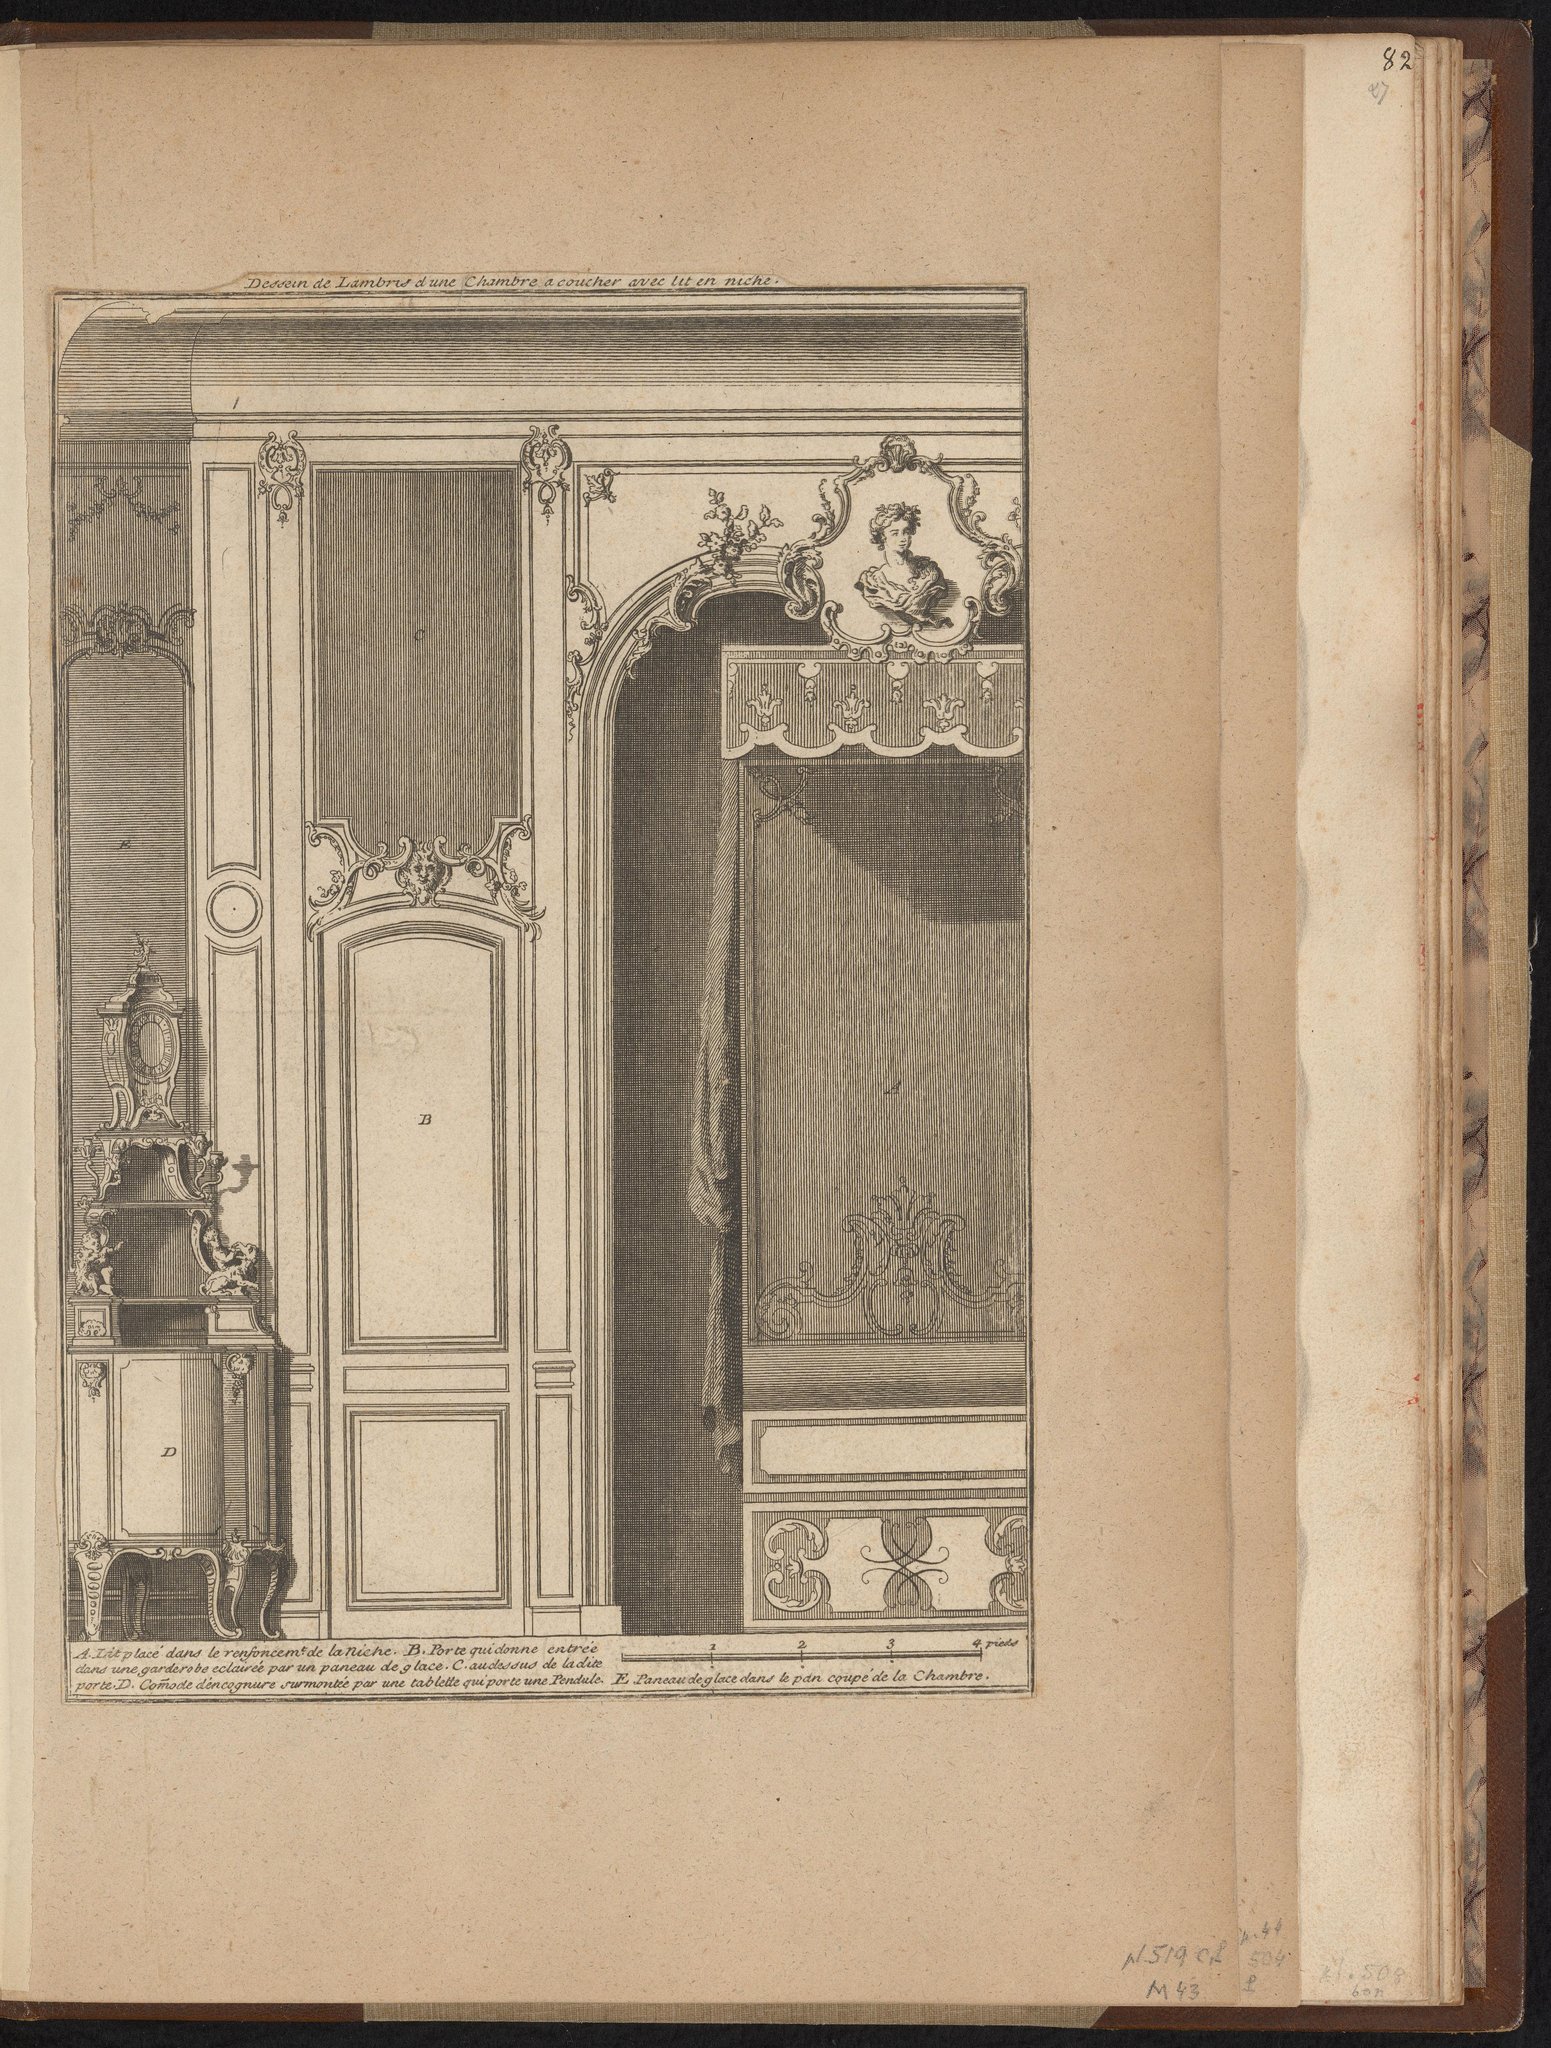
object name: print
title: Ontwerp voor het interieur van een slaapkamer met bed en kast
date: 1725-1750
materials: paper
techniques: etching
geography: paris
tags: ornamental cupboard, ornaments ~ art, bed, bedroom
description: Deze prent maakt deel uit van een album.